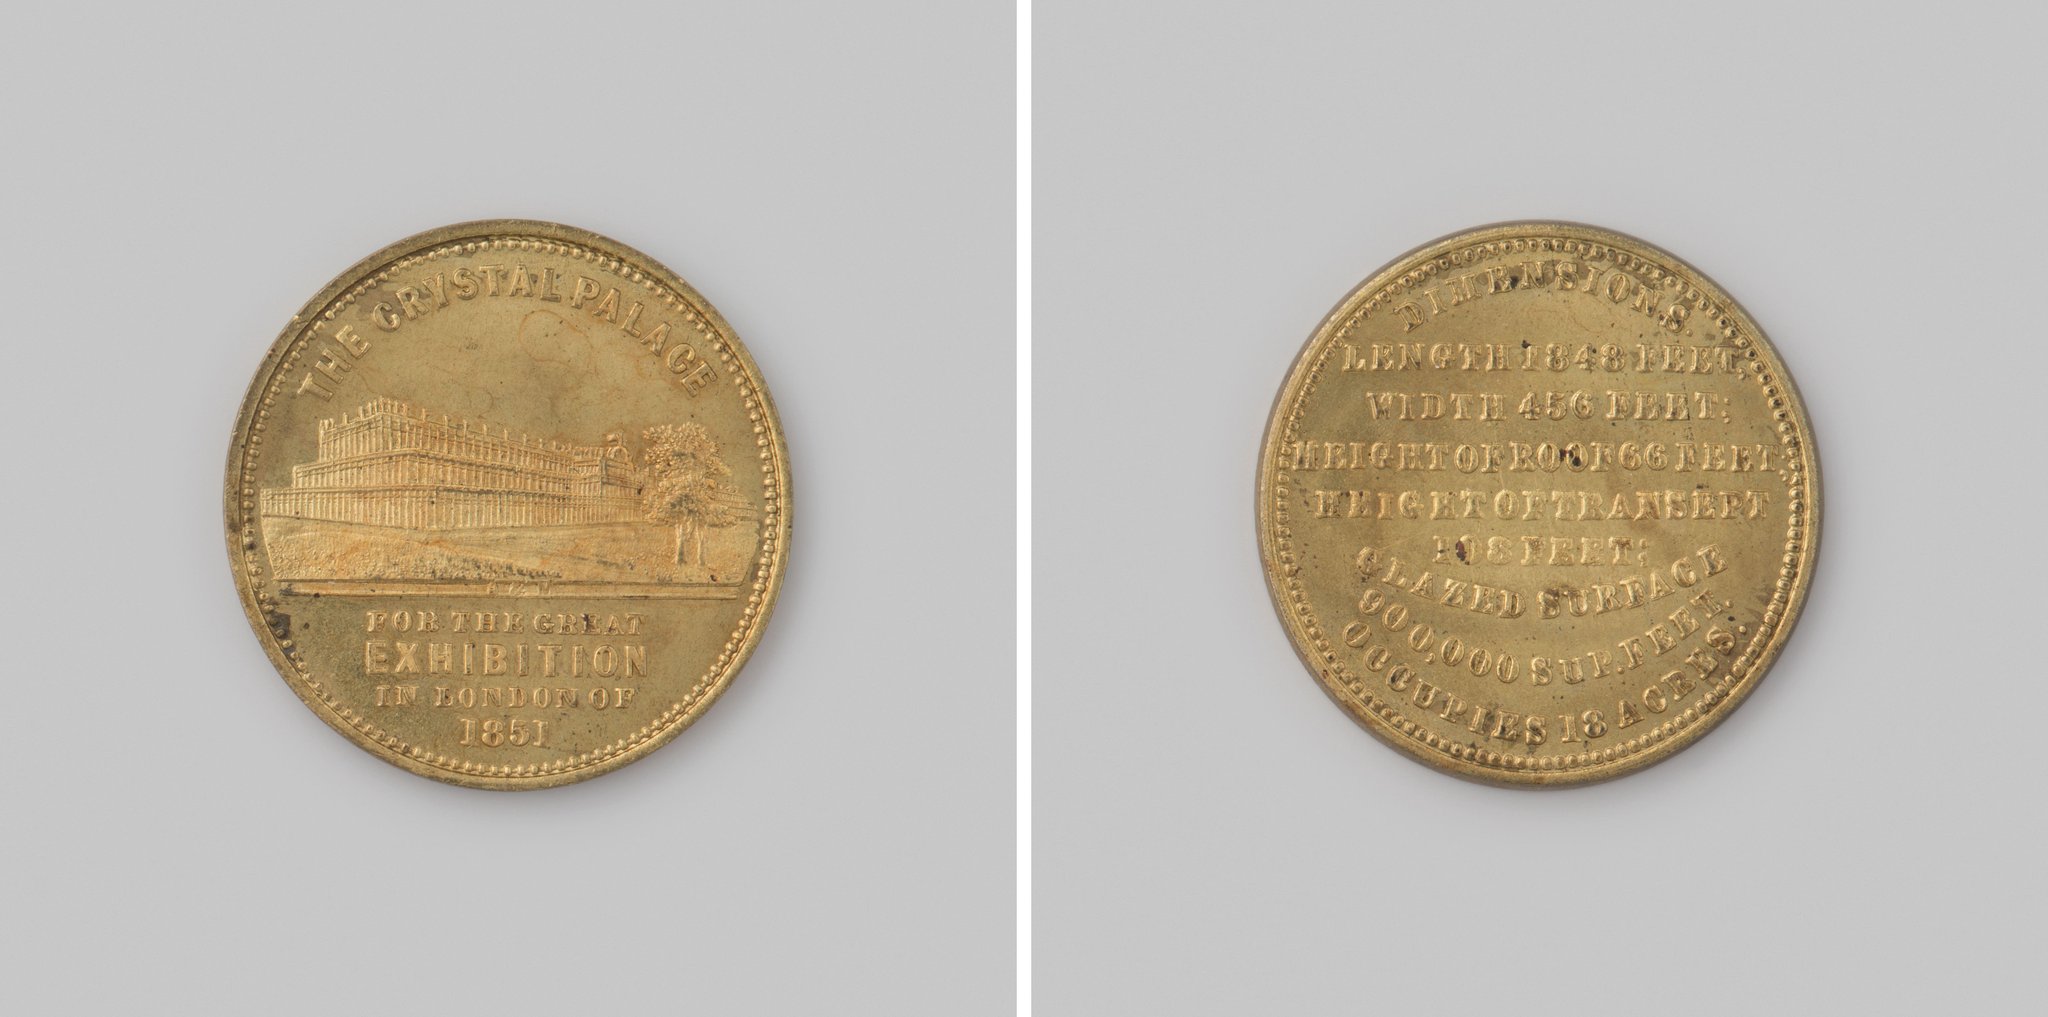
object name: history medal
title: Tentoonstelling in het Crystal Palace te Londen 1851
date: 1851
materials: brass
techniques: striking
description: Vergulde penning, op de voorzijde het aanzicht van Chrystal Palace met boven één en onder vier regels tekst, op de keerzijde negen regels tekst.